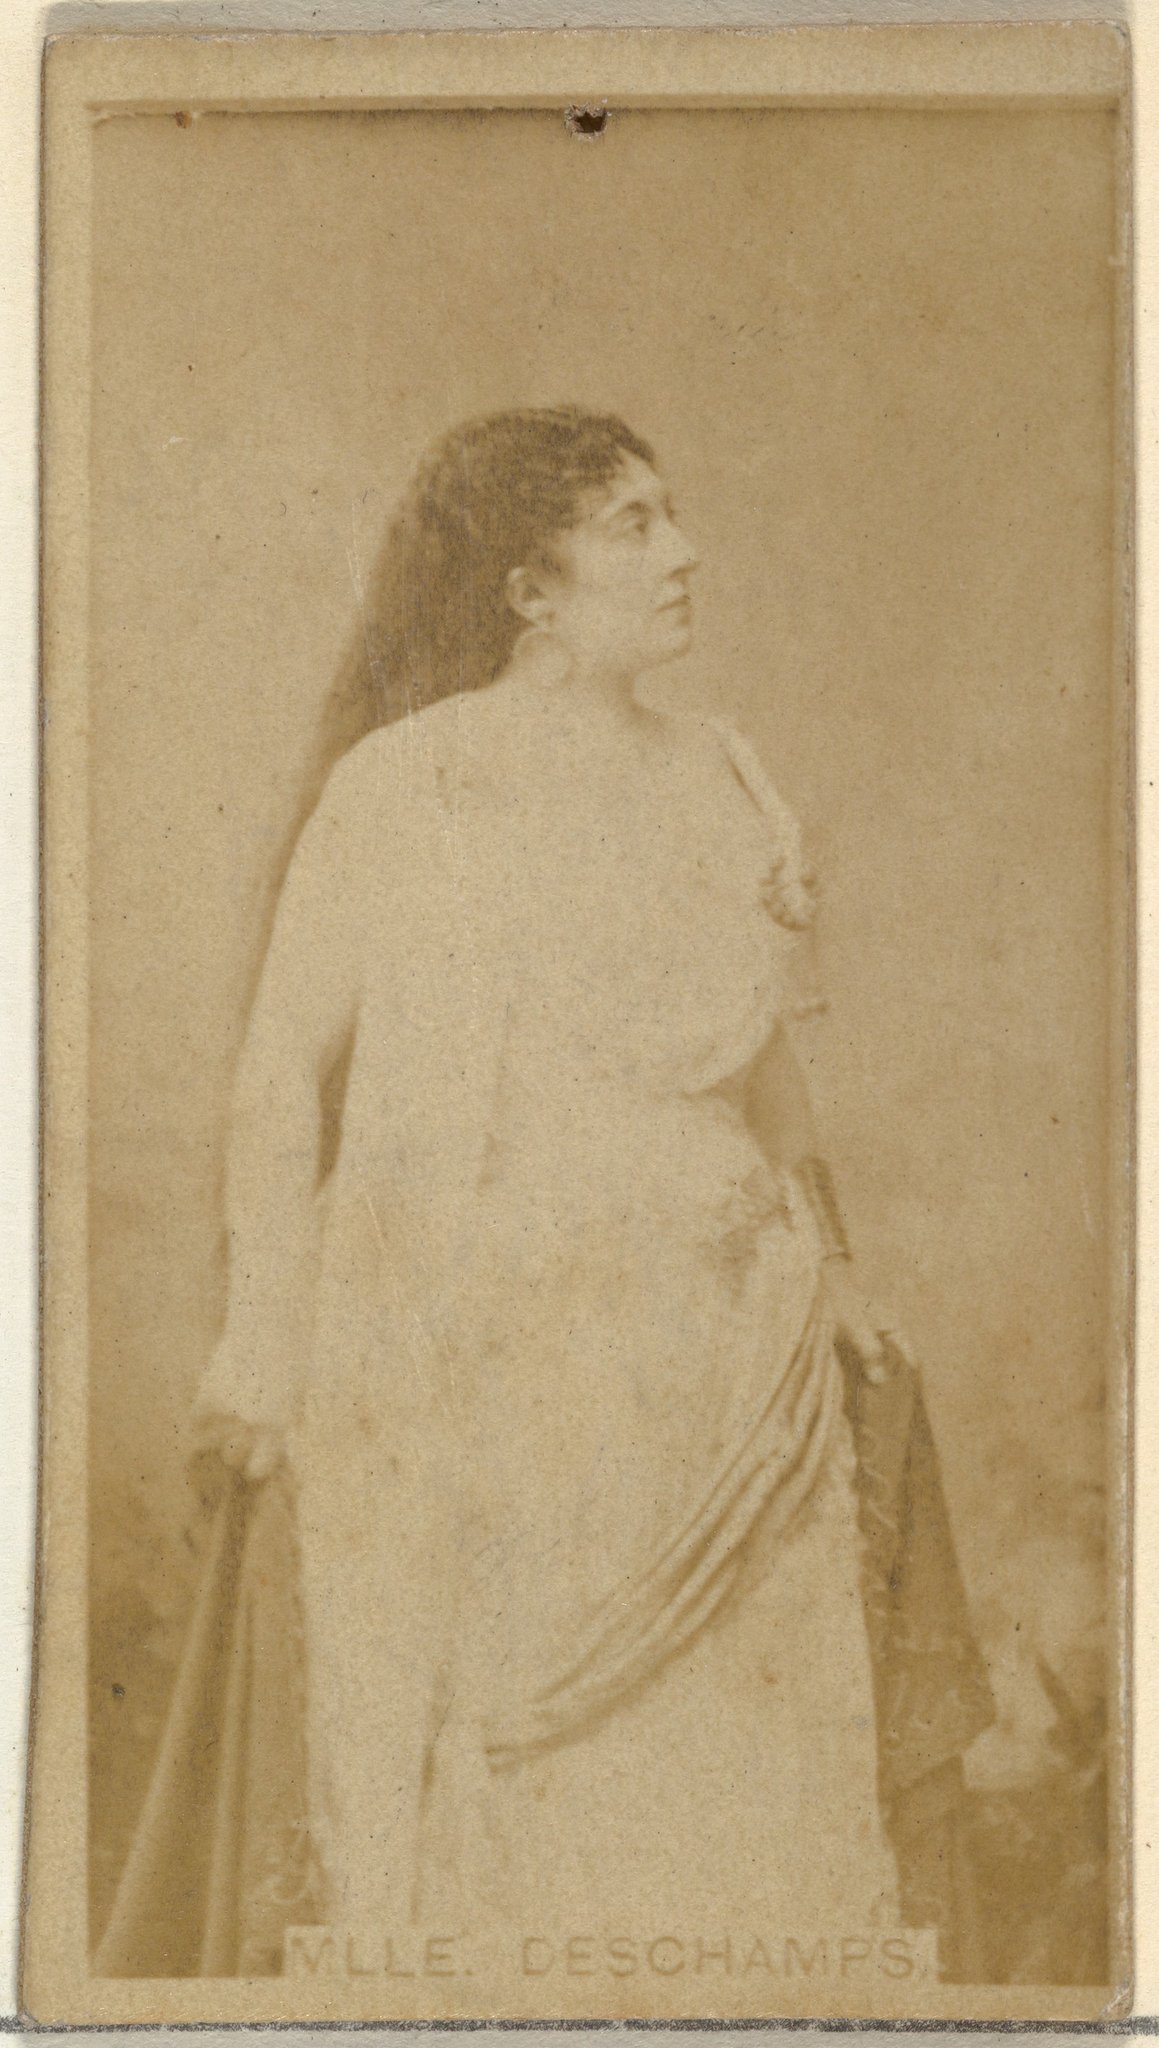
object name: photograph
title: Mlle. Deschamps, from the Actors and Actresses series (N145-8) issued by Duke Sons & Co. to promote Duke Cigarettes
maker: w. duke, sons & co.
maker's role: publisher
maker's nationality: american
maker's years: 1870-1920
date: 1891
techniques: albumen silver print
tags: portraits,women,actresses